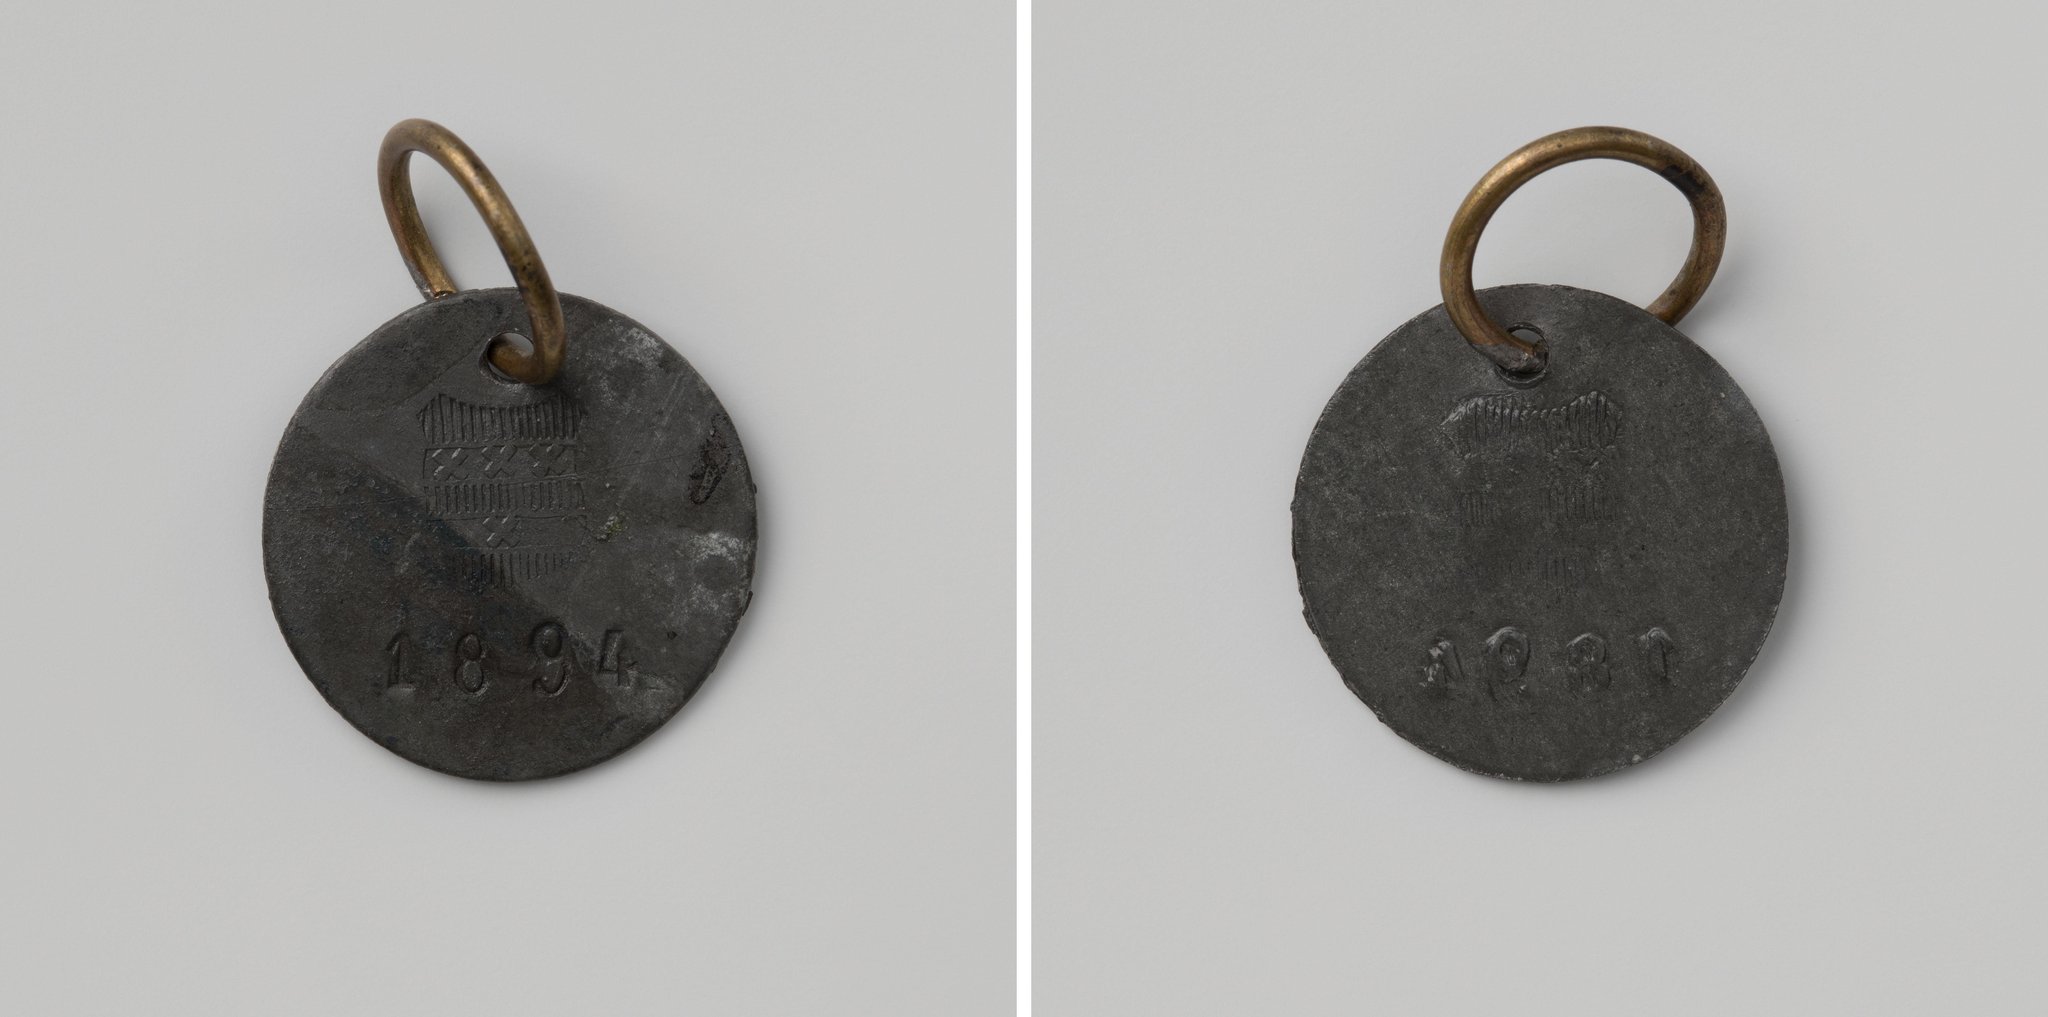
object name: tax token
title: Gemeente Nieuwer Amstel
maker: Anonymous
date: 1894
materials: brass, tin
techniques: silvering, striking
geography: netherlands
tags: nieuwer-amstel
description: Eenzijdig loodje aan draagring. Voorzijde: wapenschild boven jaartal. Keerzijde: blanco.